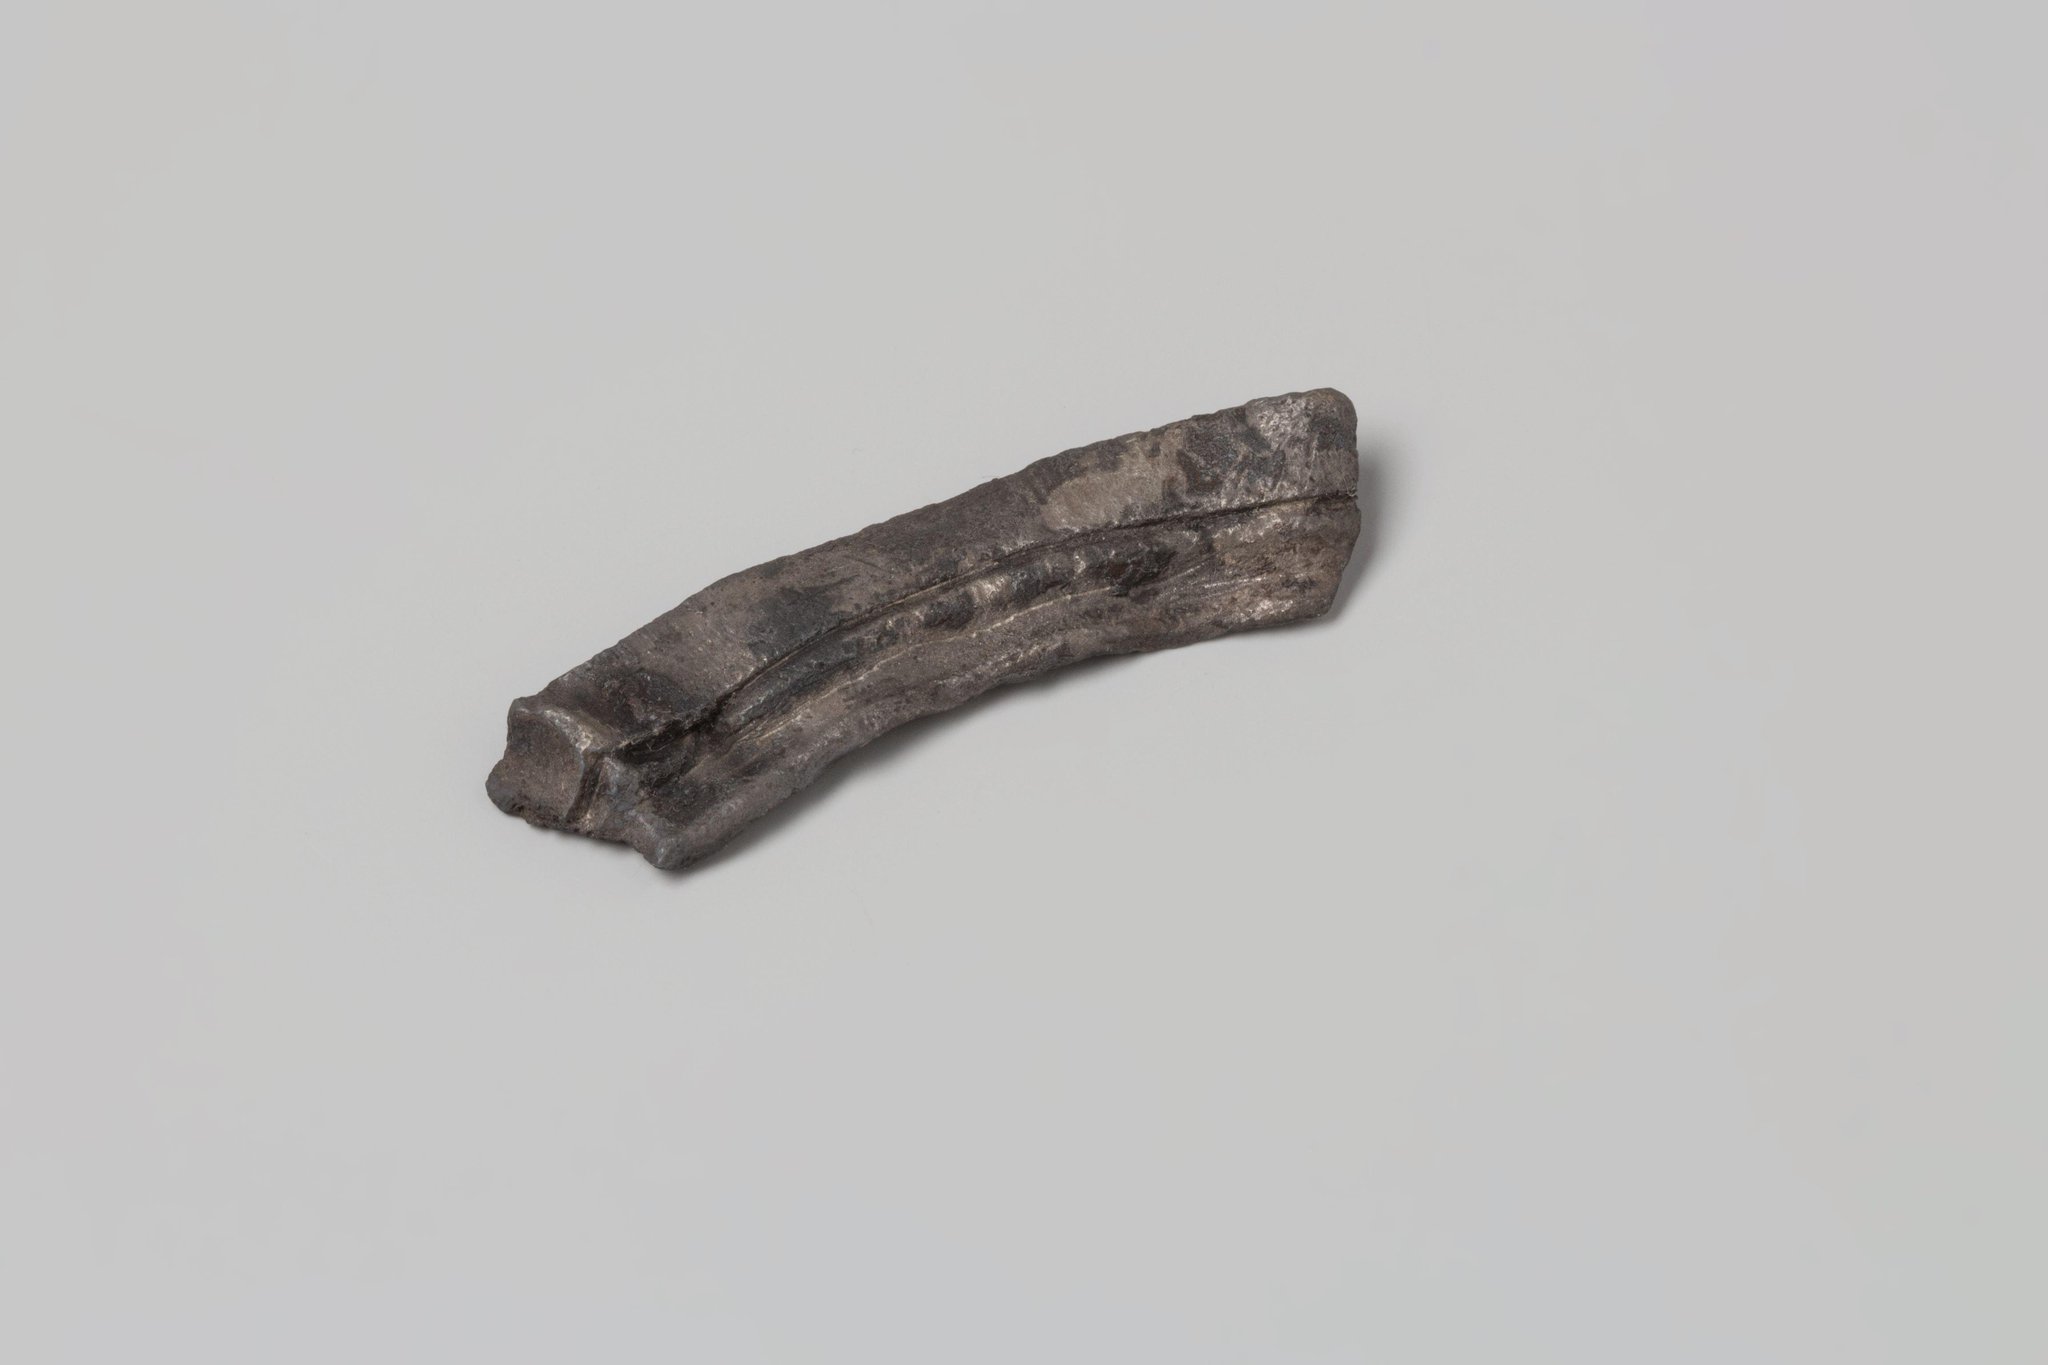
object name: candlestick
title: Fragment voet van een kandelaar uit het wrak van de Oost-Indiëvaarder Hollandia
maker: Anonymous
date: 1700-1743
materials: silver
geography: netherlands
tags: verenigde oostindische compagnie, hollandia (schip), annet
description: Candlestick, foot; fragm of moulded rim, sim. NG 1980-27H2812.